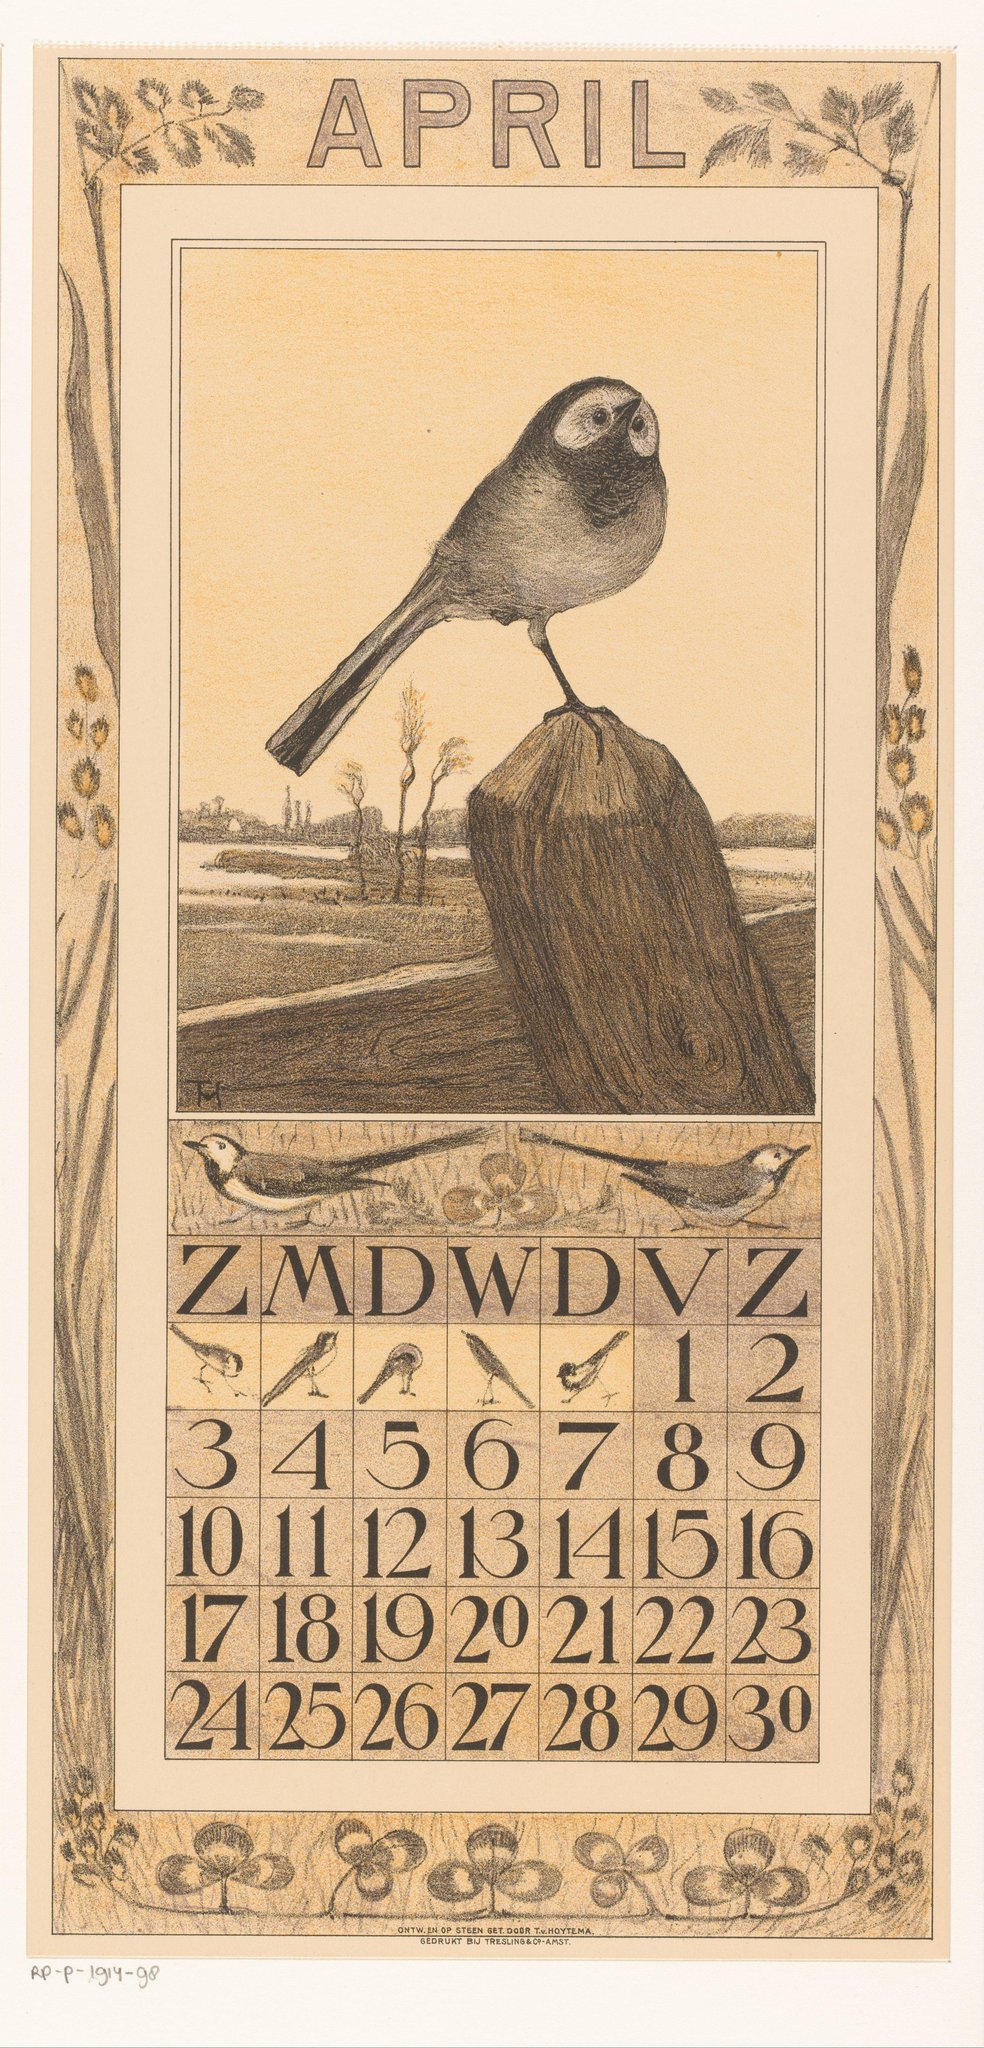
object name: print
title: Kwikstaart, op de paal van een hek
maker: theo van hoytema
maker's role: draughtsman, painter, print maker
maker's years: 1863-1917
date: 1909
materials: paper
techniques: lithograph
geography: the hague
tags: song-birds: wagtail, april ~ other concepts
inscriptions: collector's mark: Lugt 2228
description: De vogel heeft een poot opgetrokken. Bovenaan het blad een scheurlijn.